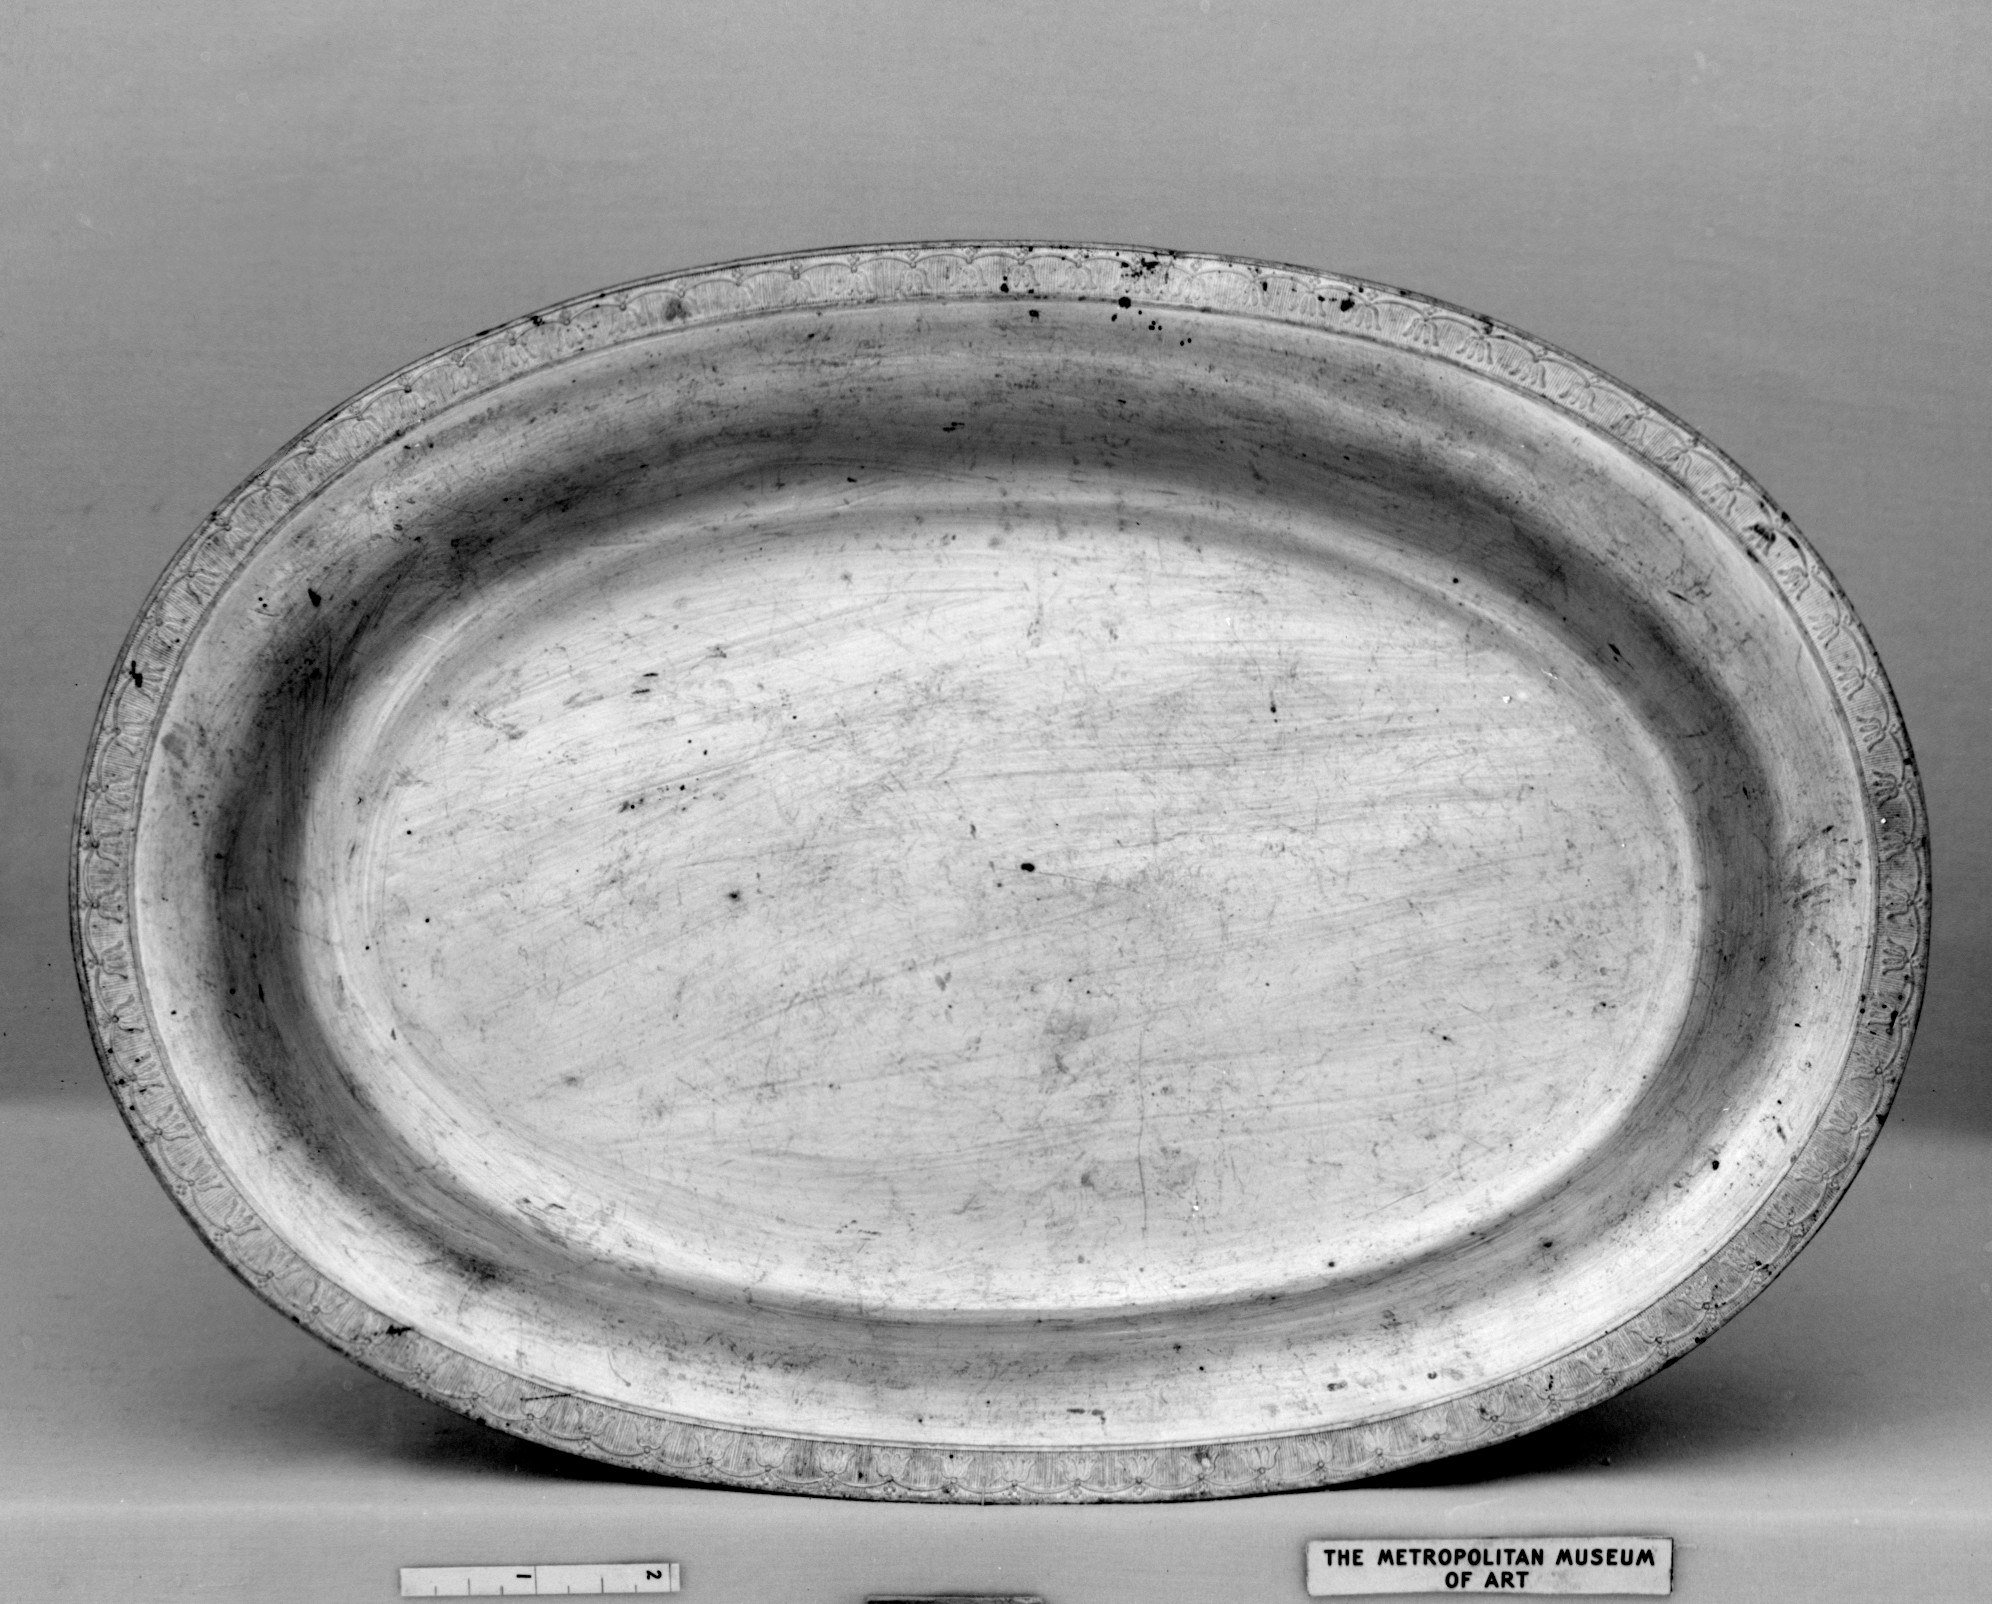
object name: basin or dish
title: Dish or basin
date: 1801-1900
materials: pewter